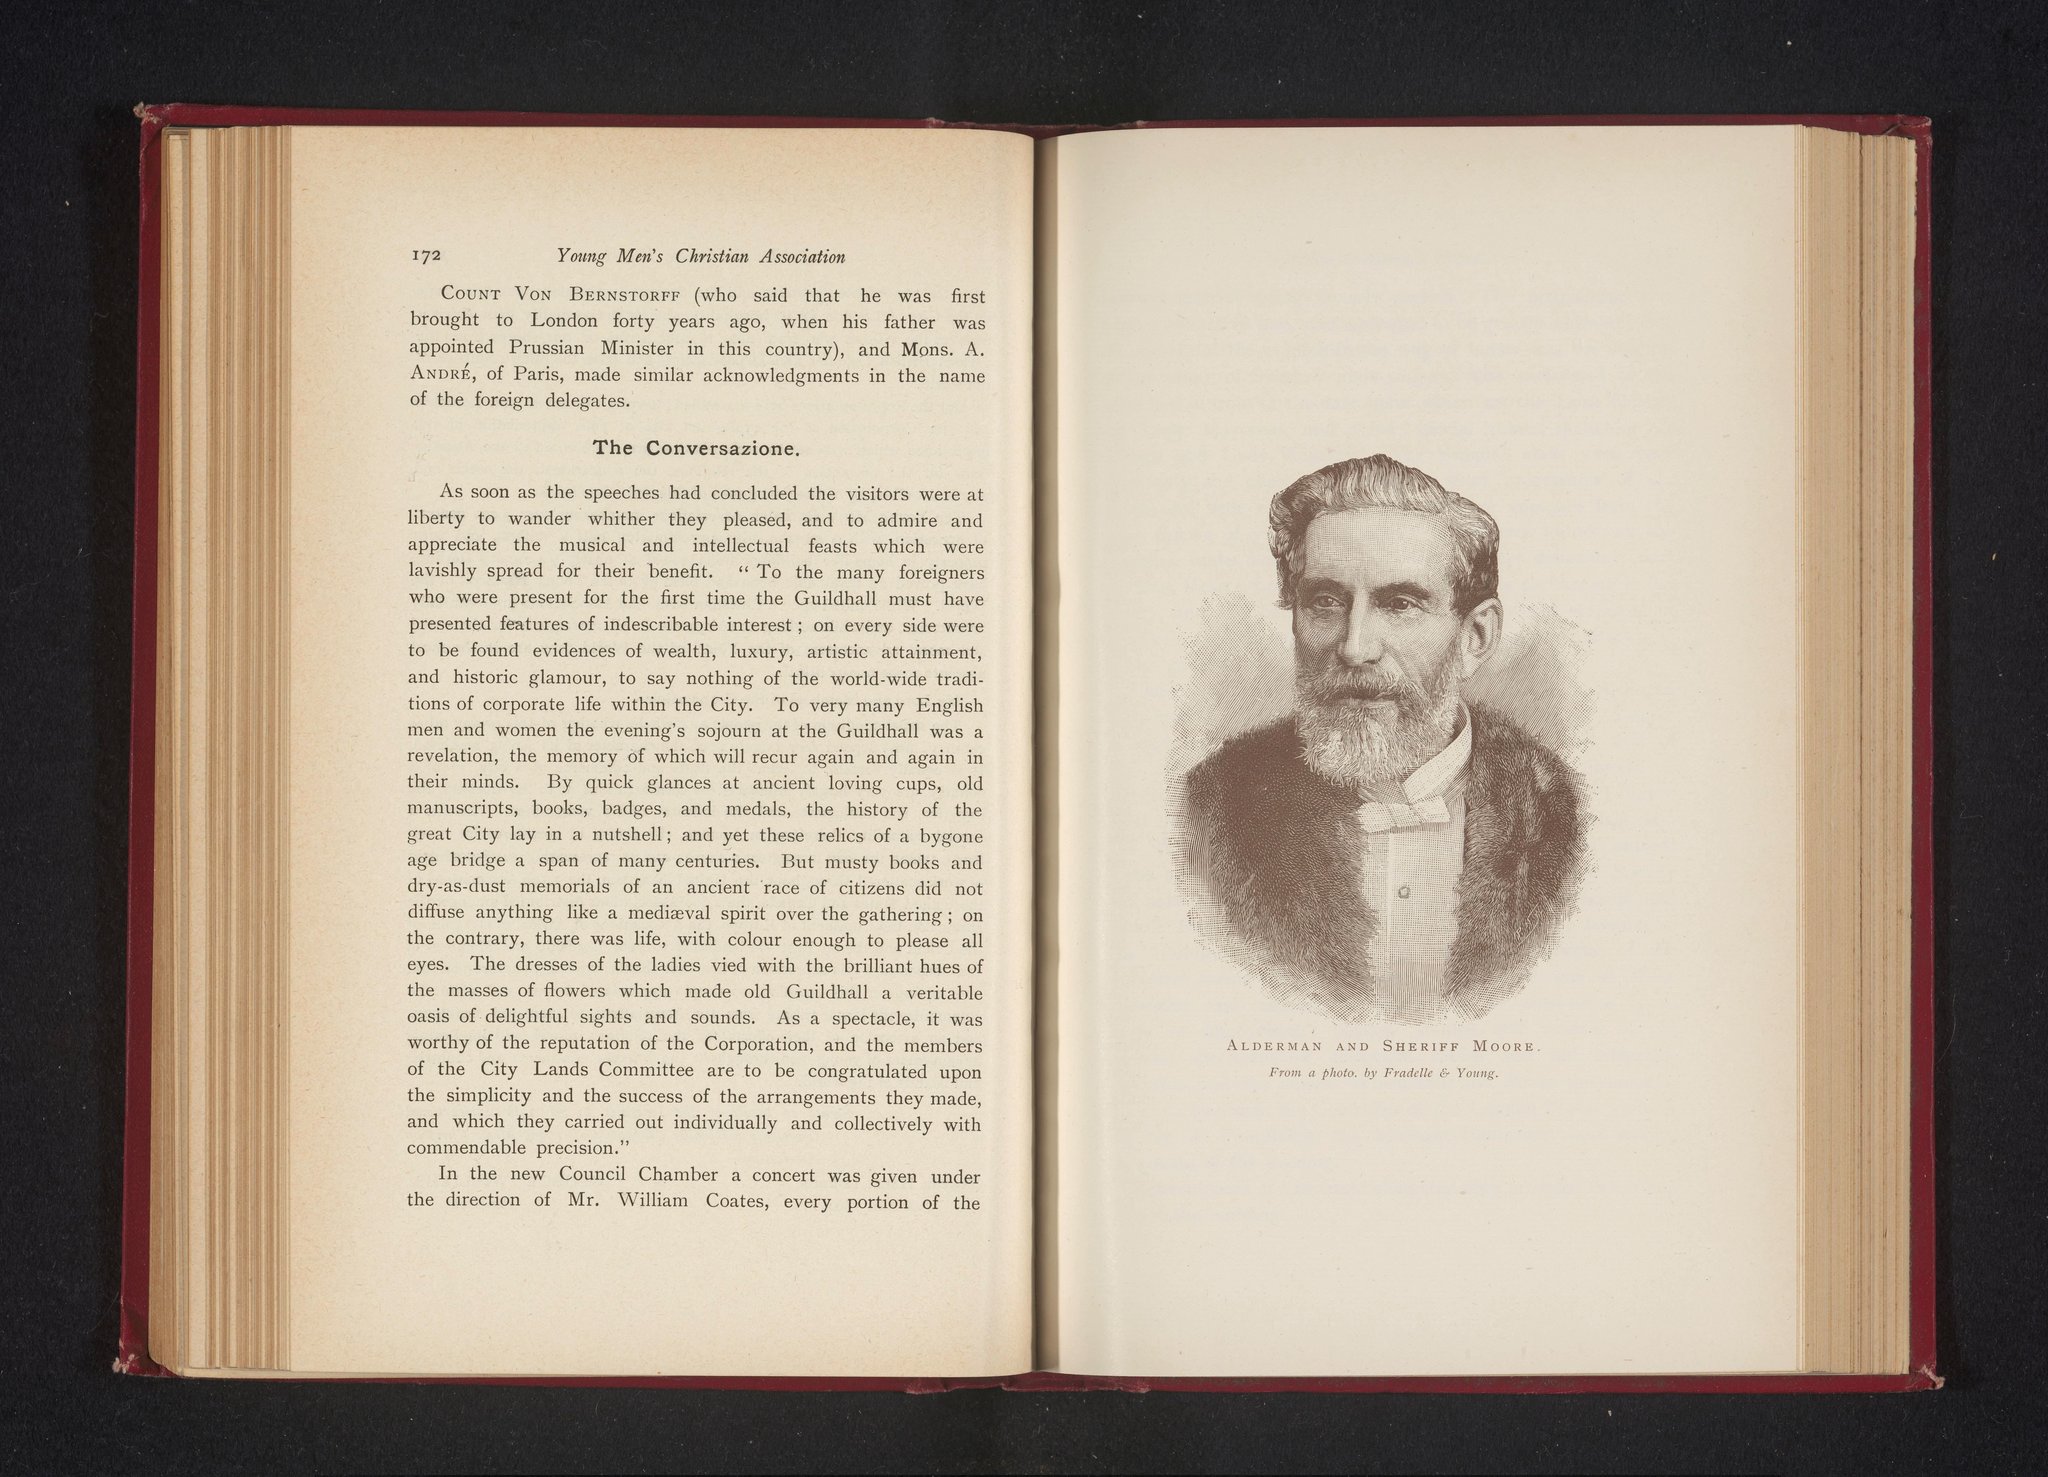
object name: page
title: Reproductie van een foto van een portret van wethouder en sheriff Moore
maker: Anonymous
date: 1890-1895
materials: paper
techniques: engraving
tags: historical persons